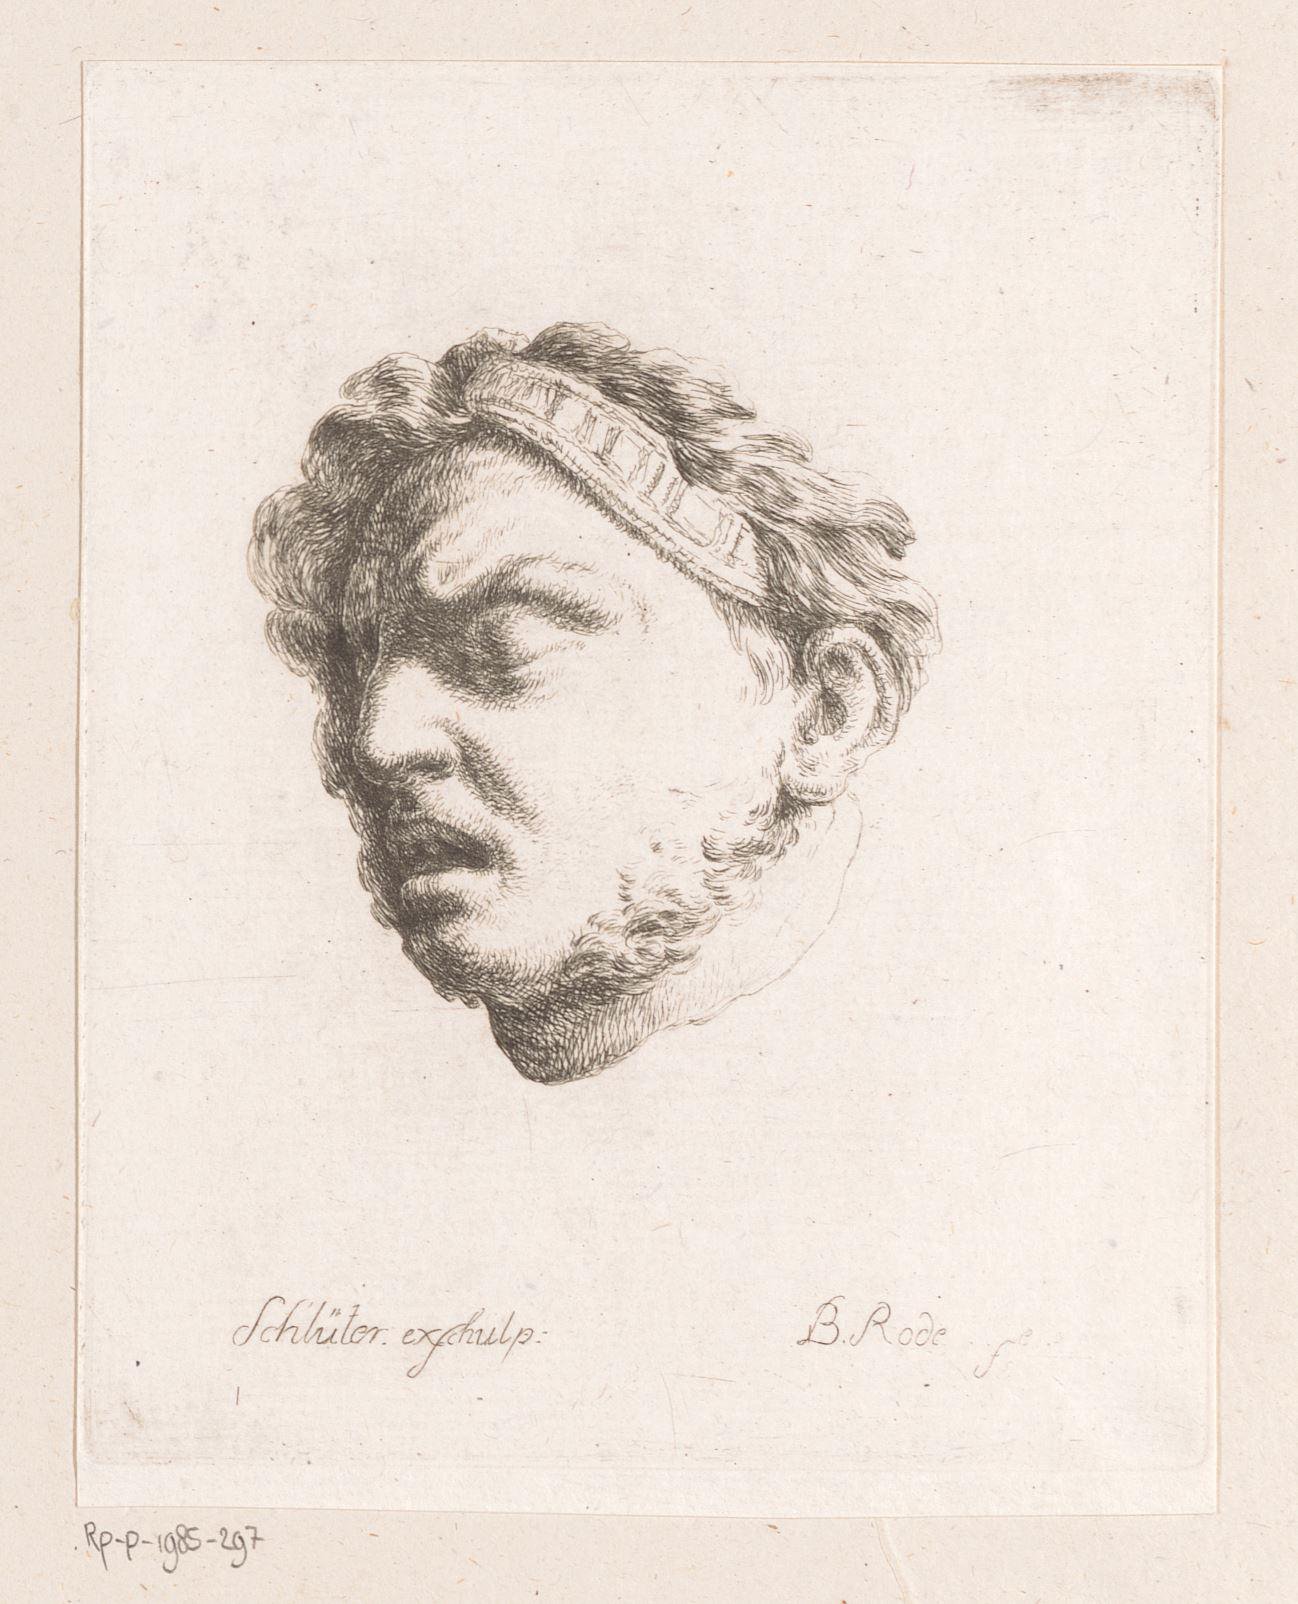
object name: print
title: Mascarons en helmen van het Zeughaus te Berlijn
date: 1759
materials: paper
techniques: etching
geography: berlin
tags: face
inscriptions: collector's mark: Lugt 2760, collector's mark: Lugt 2228